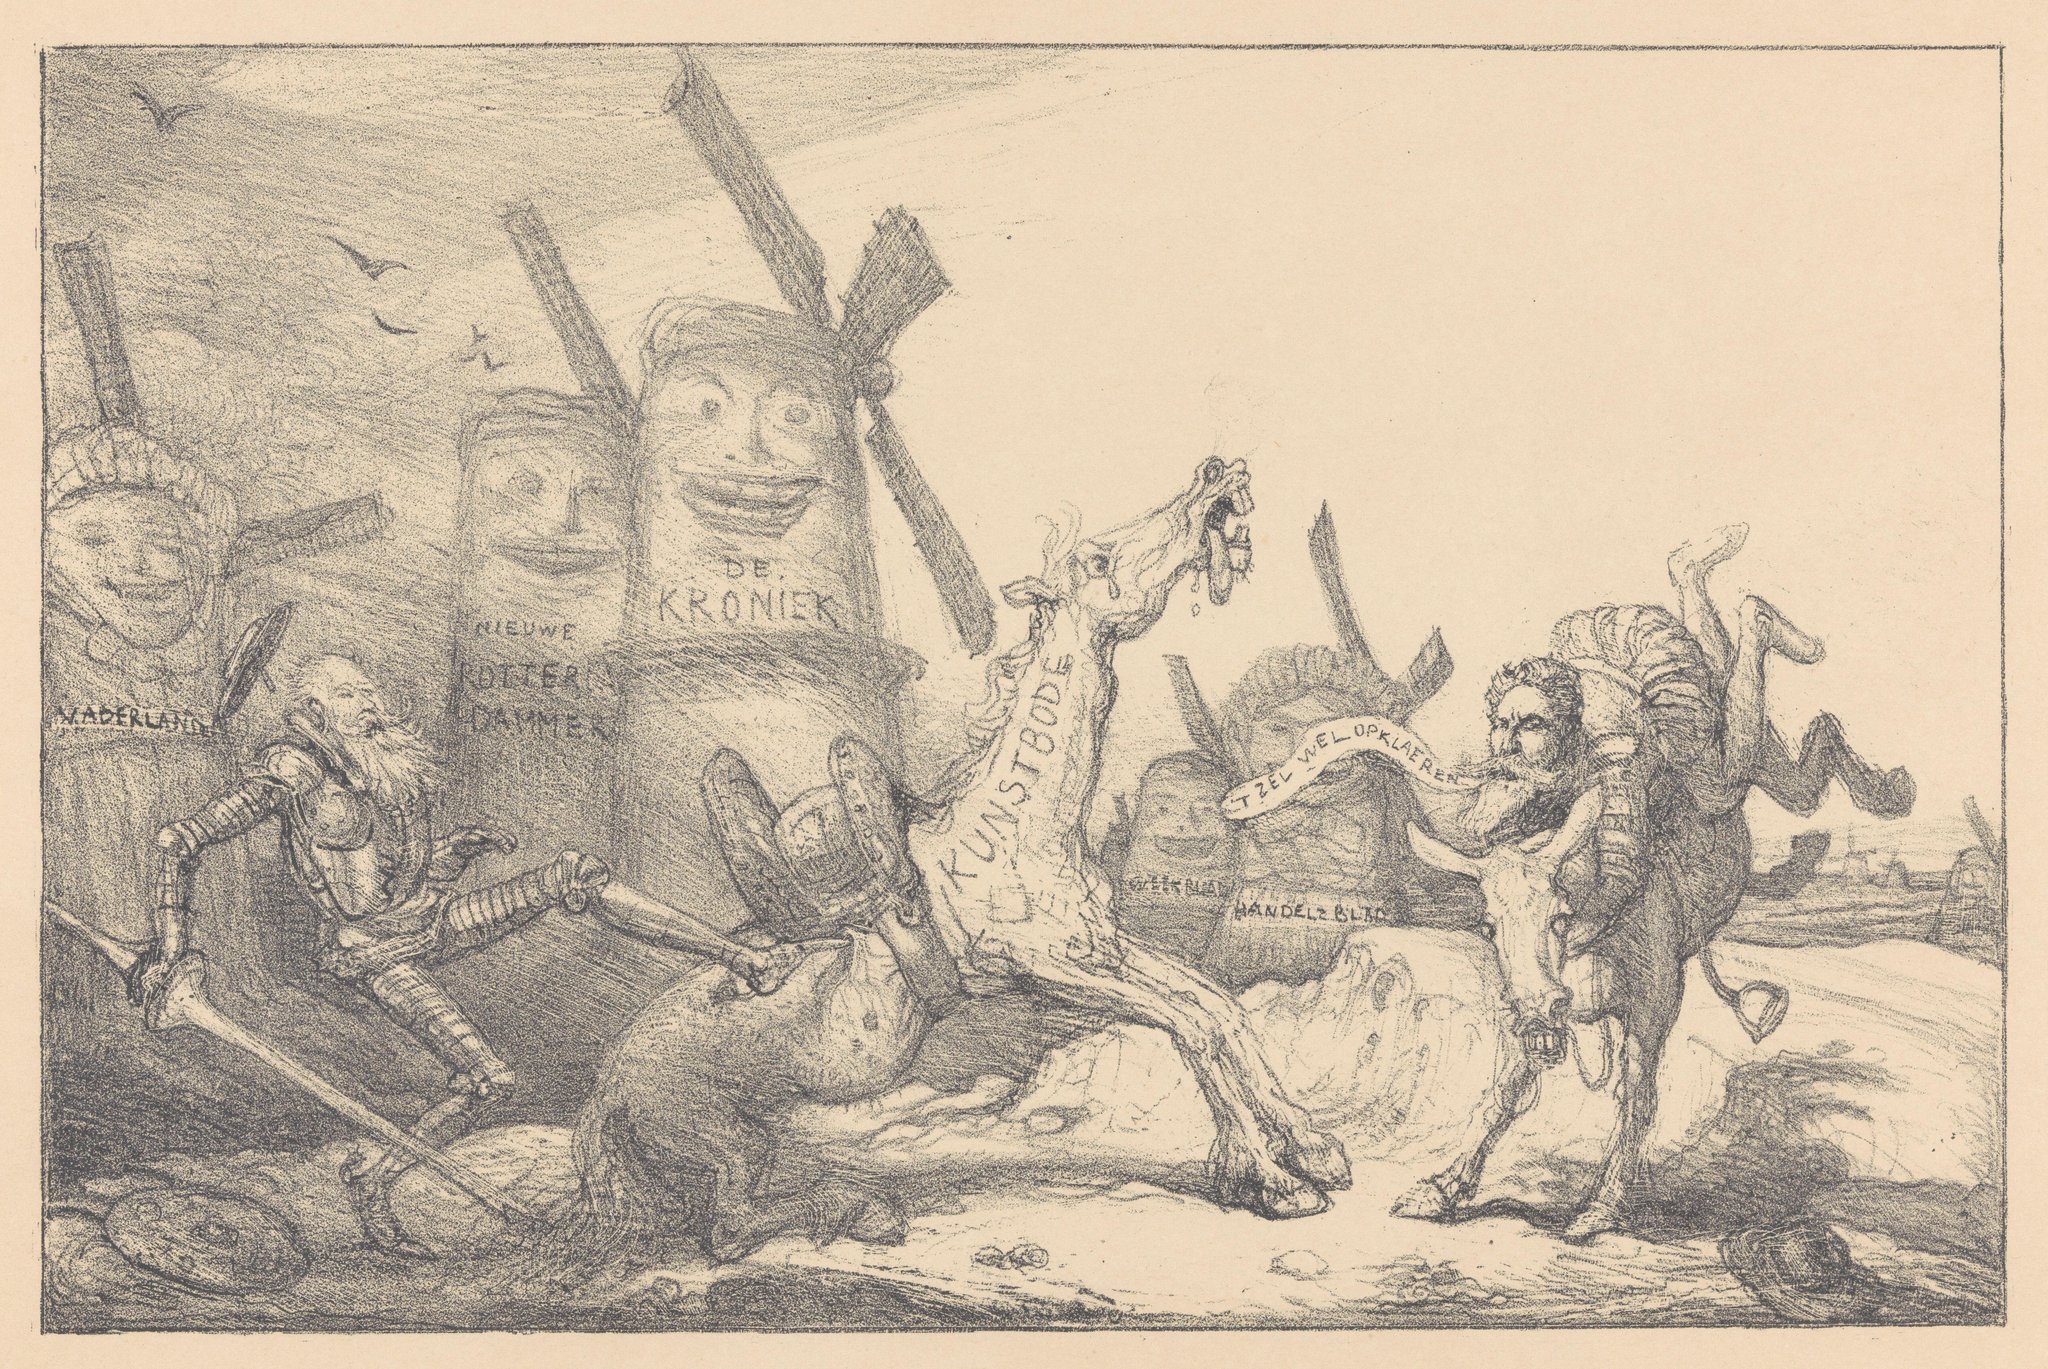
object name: cartoon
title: Loos alarm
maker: marius bauer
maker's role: draughtsman, print maker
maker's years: 1867-1932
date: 1895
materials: paper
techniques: lithograph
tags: painter, print maker, draughtsman, johannes gijsbert vogel, pieter anne haaxman, political caricatures and satires, netherlands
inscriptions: collector's mark: Lugt 2228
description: Spotprent op de mislukte plannen voor de oprichting van het tijdschrift De Kunstbode, door J.G. Vogel en P.A. Haaxman jr. De Kunstbode als Don Quichotte strijdend tegen de lachende windmolens van Het Vaderland, De Kroniek, De Nieuwe Rotterdammer en het Handelsblad. Verschenen in het bijvoegsel van 'De Kroniek' van 22 december 1895.